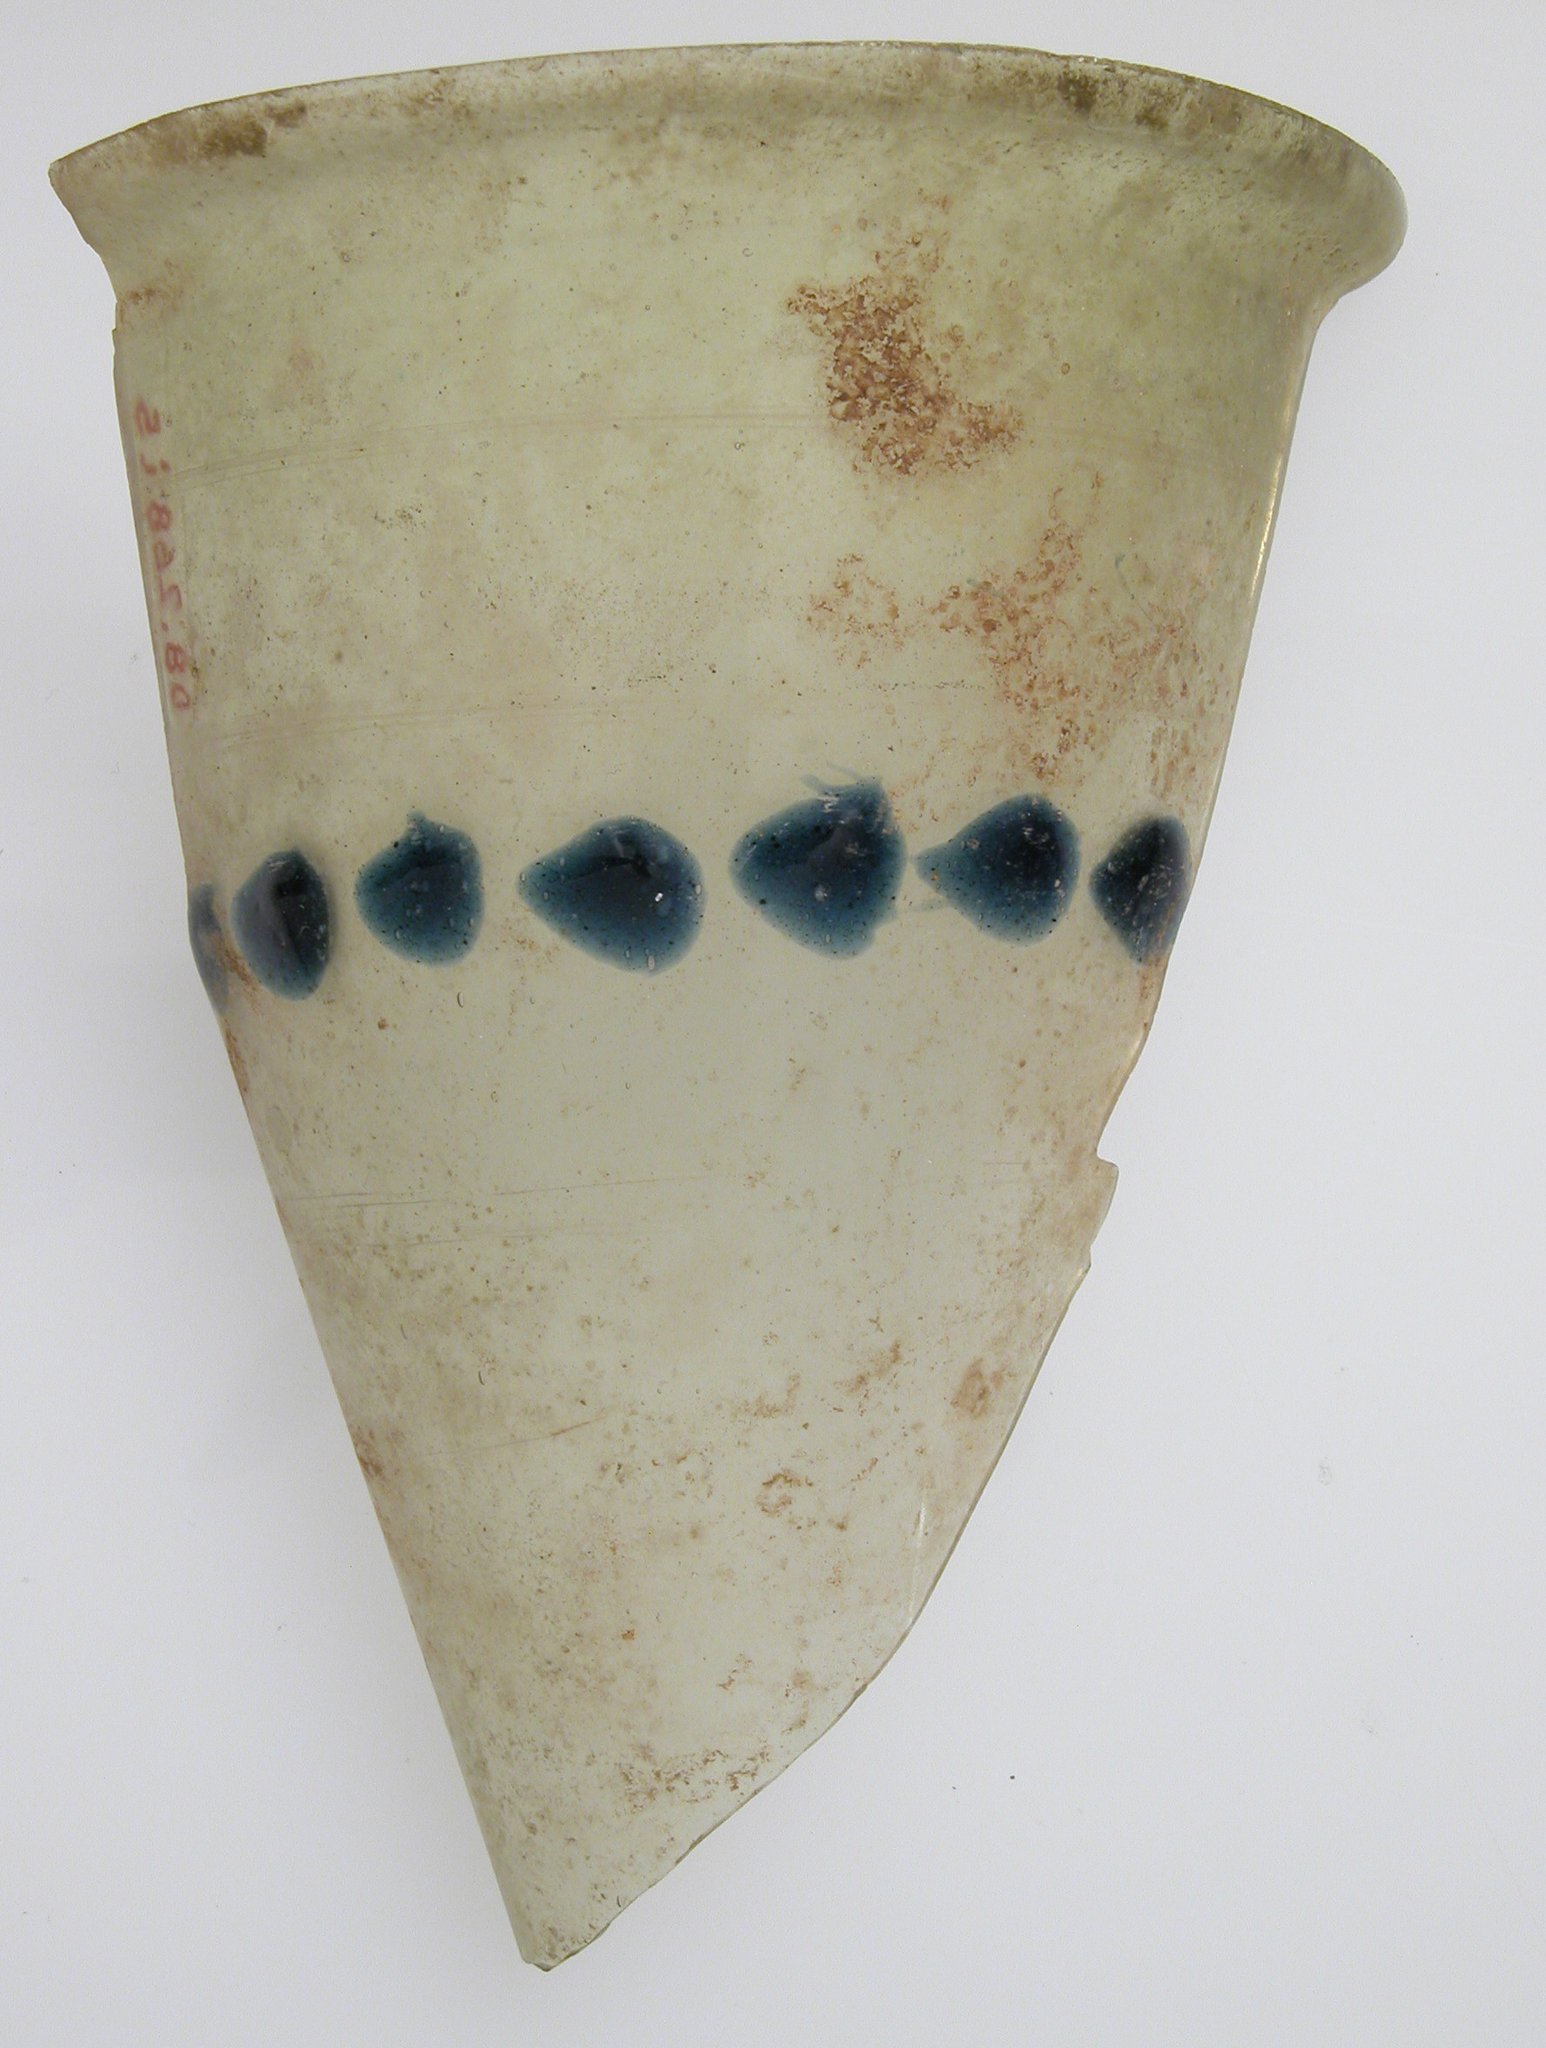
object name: fragment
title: Glass Fragment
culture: coptic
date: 301-433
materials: glass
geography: egypt